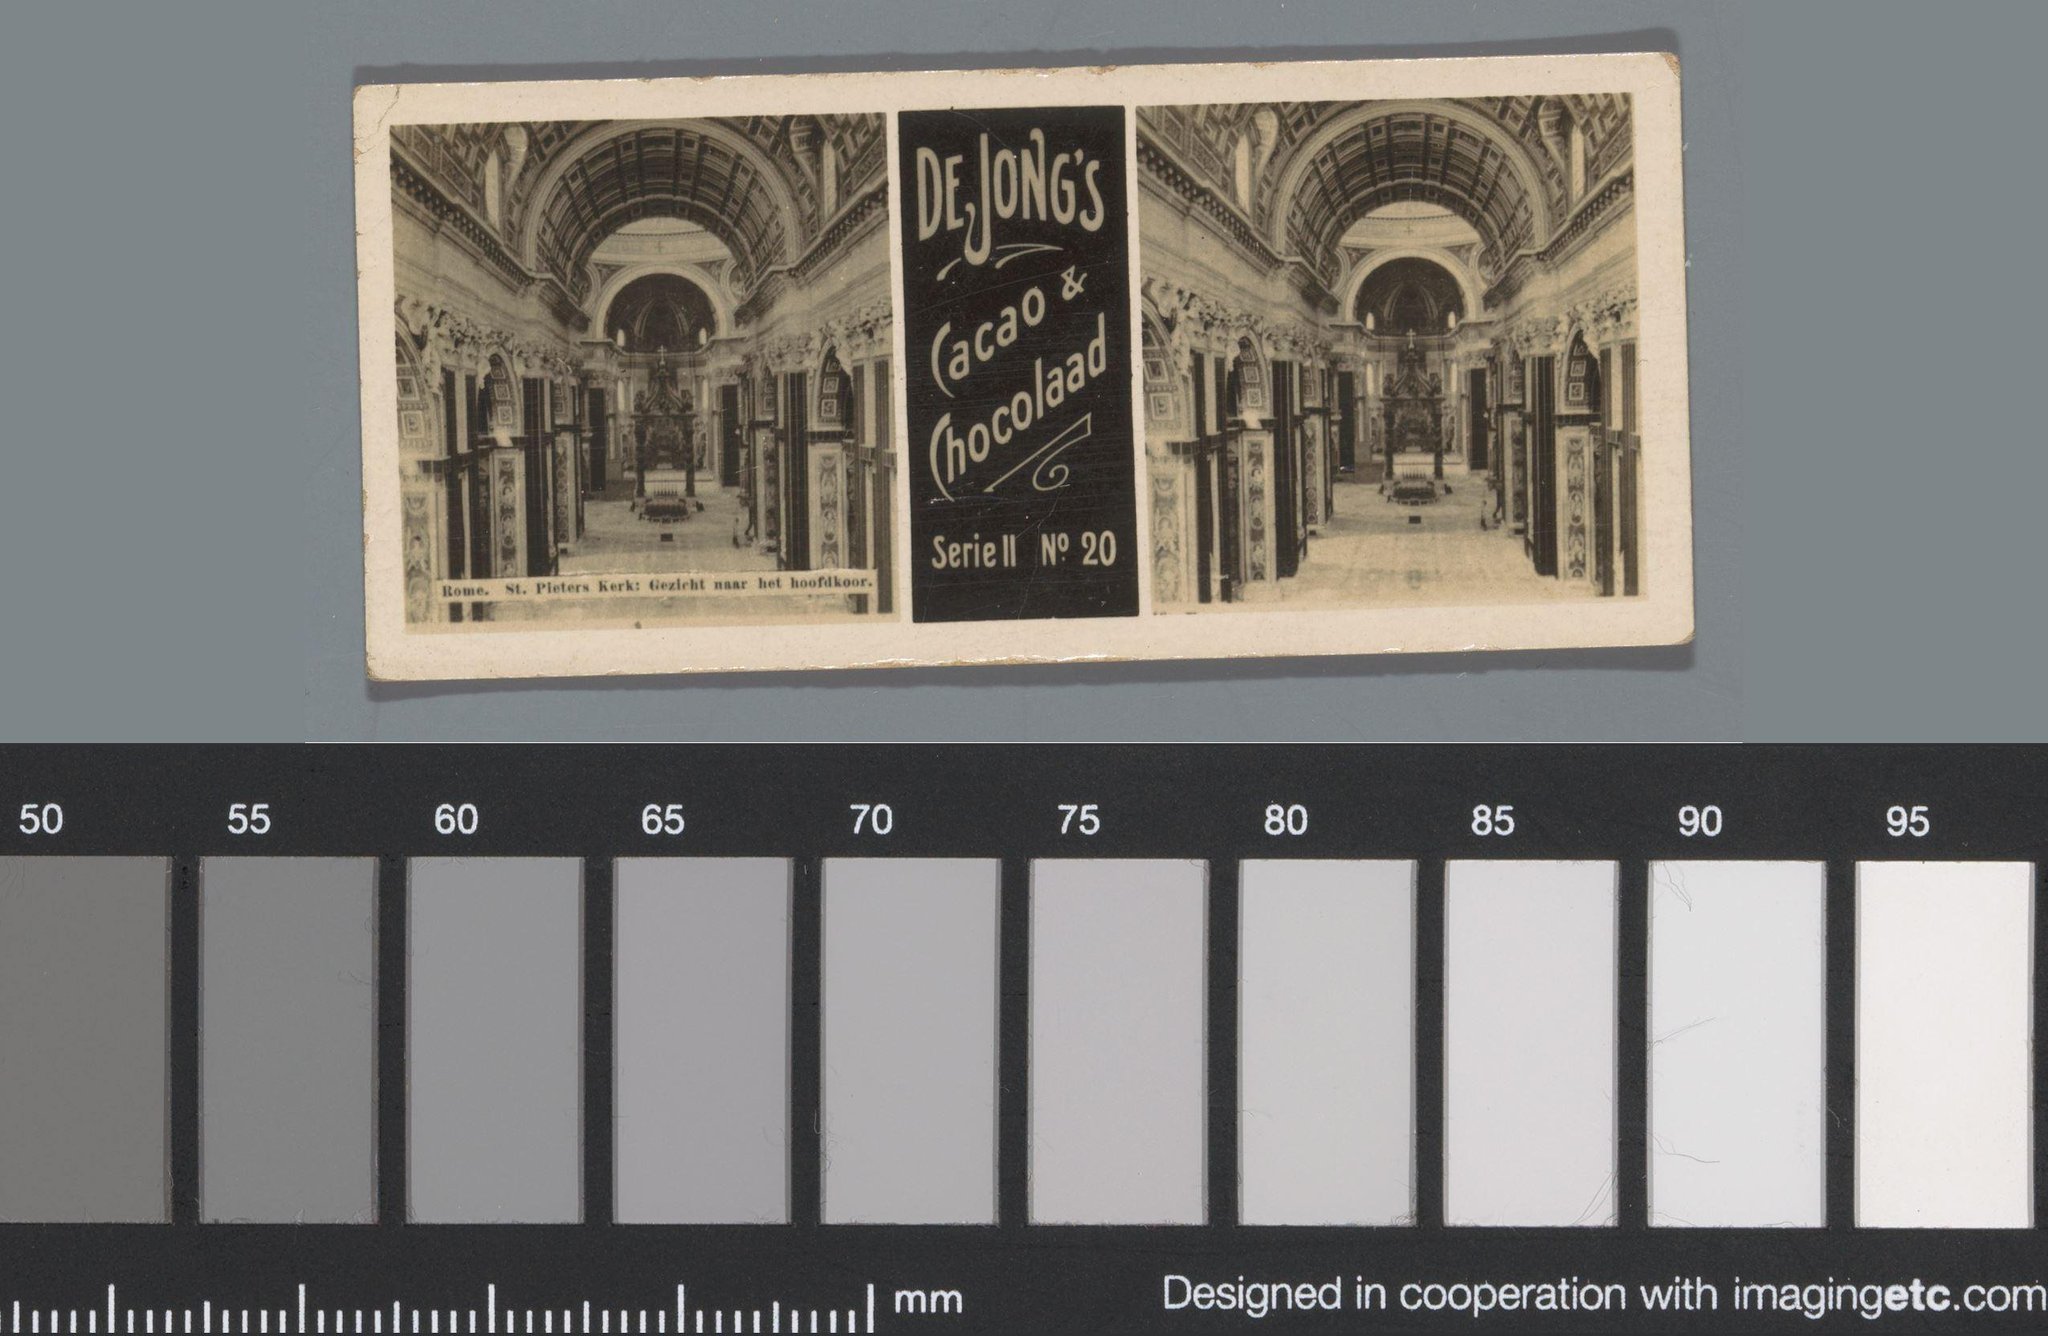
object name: stereograph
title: Interieur van de Sint-Pietersbasiliek te Vaticaanstad, met zicht op het koor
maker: Anonymous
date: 1900-1910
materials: cardboard, photographic support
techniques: gelatin silver print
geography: wormerveer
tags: parts of church interior: aisle, interior of church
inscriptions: number: ‘Serie II No. 20’, inscription: ‘De Jong's Cacao & Chocolaad’